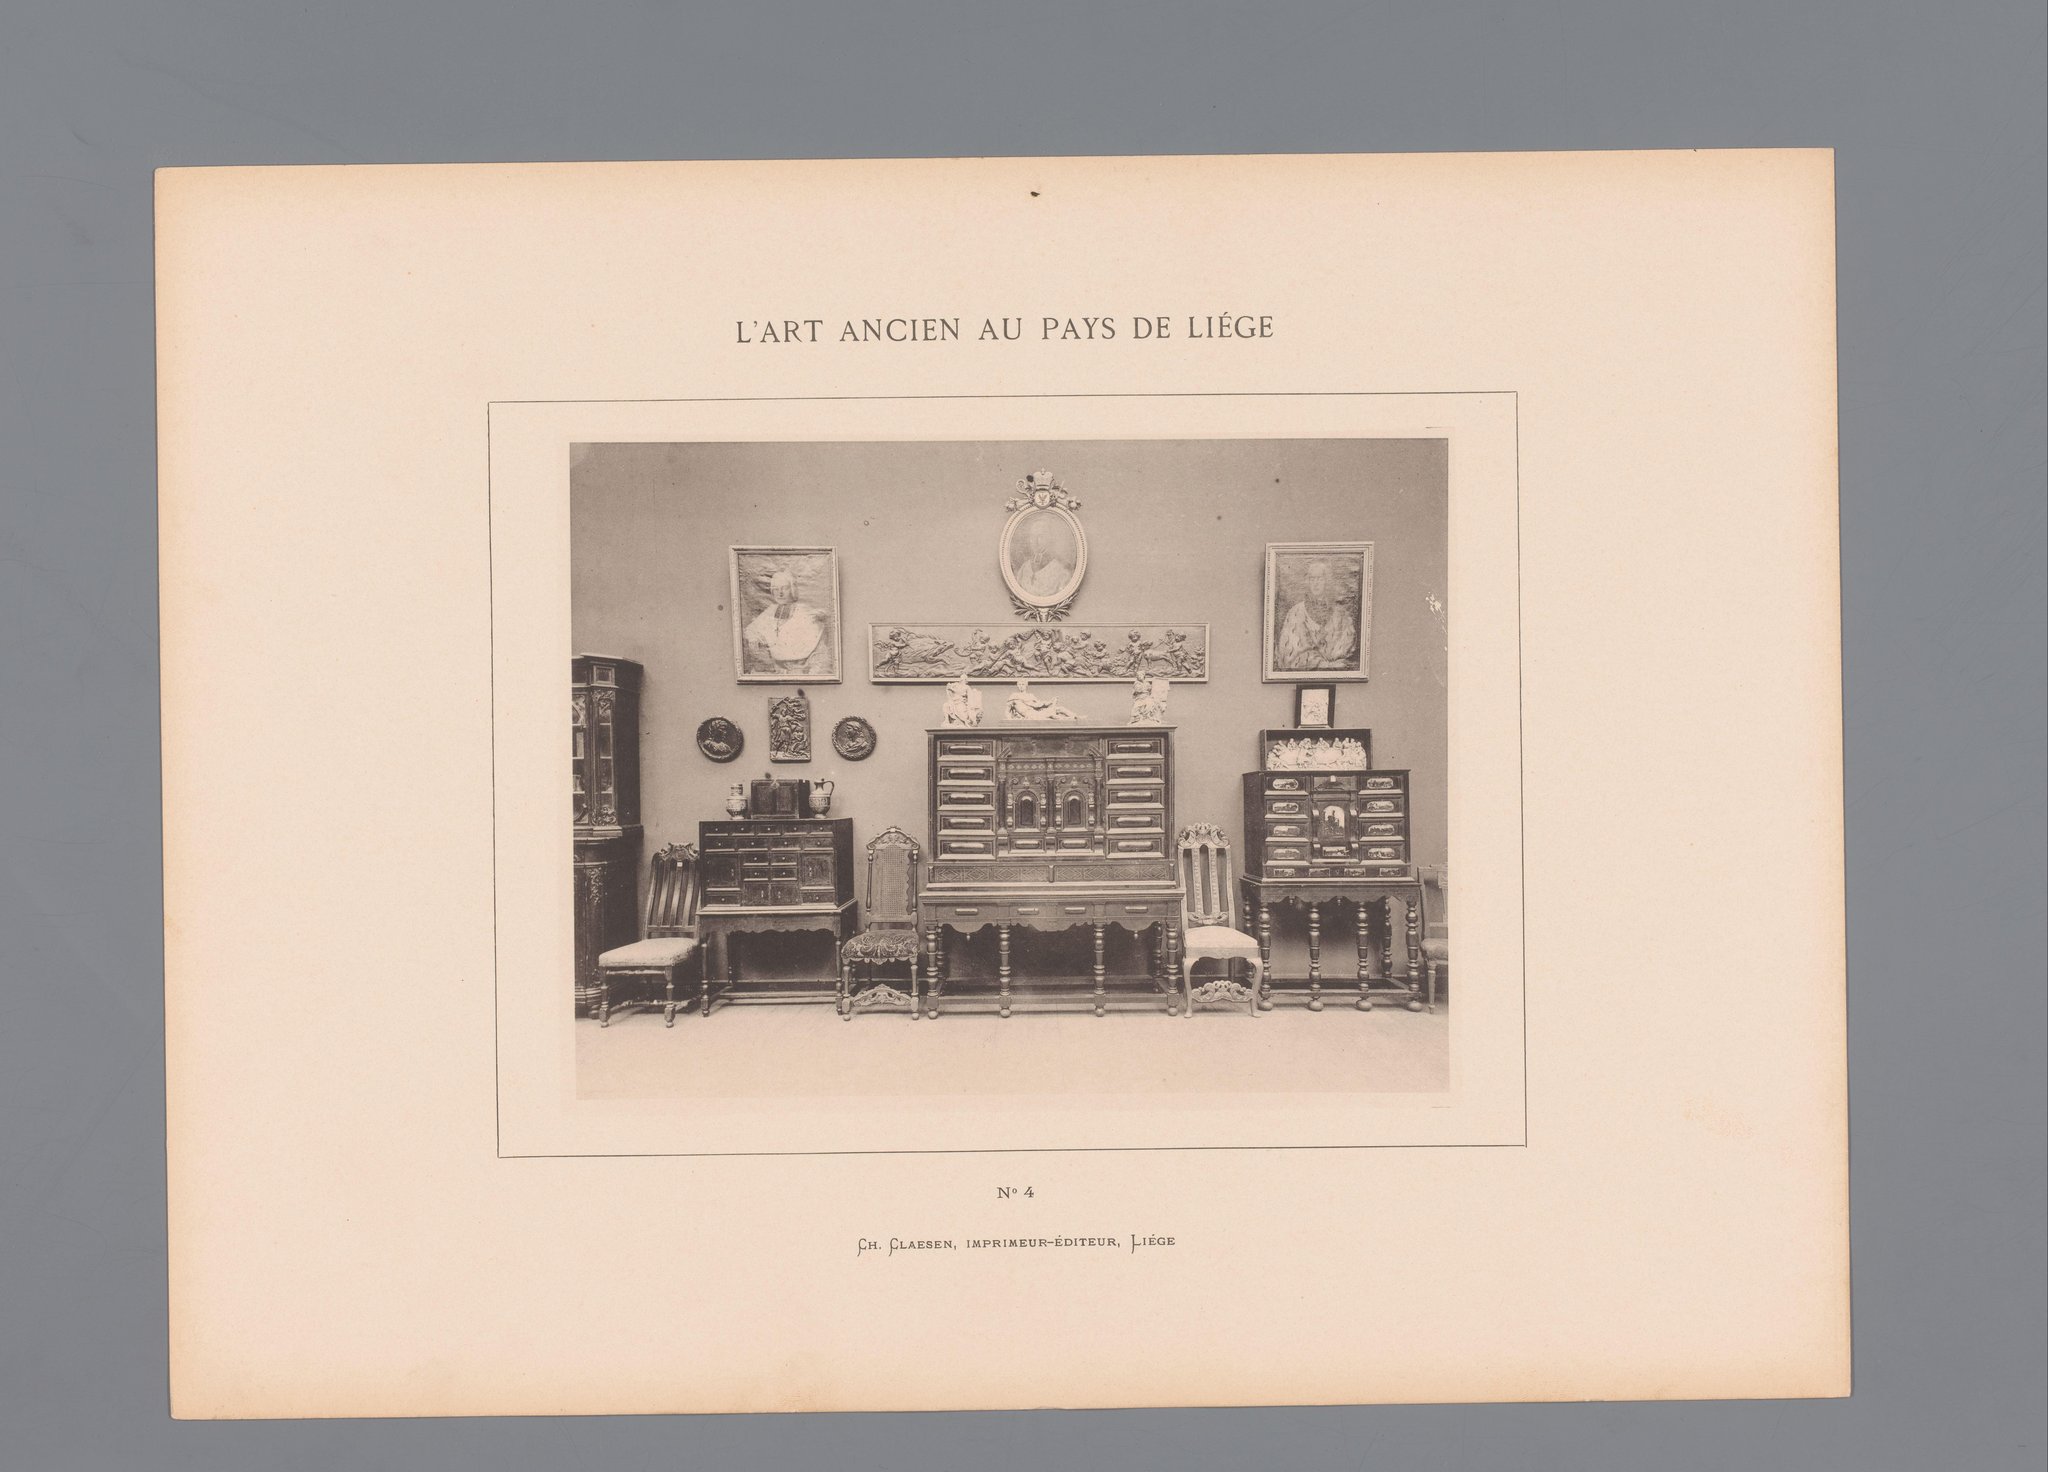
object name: photomechanical print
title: Diverse houten meubels, opgesteld in het archeologisch museum in Luik, België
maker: Anonymous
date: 1879-1884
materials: paper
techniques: photograph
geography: liège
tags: permanent exhibition, museum, furniture and household effects, liège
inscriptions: number: ‘No 4’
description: Deze prent maakt deel uit van een omslag met twintig prenten, een titelblad en een lijst van afbeeldingen.